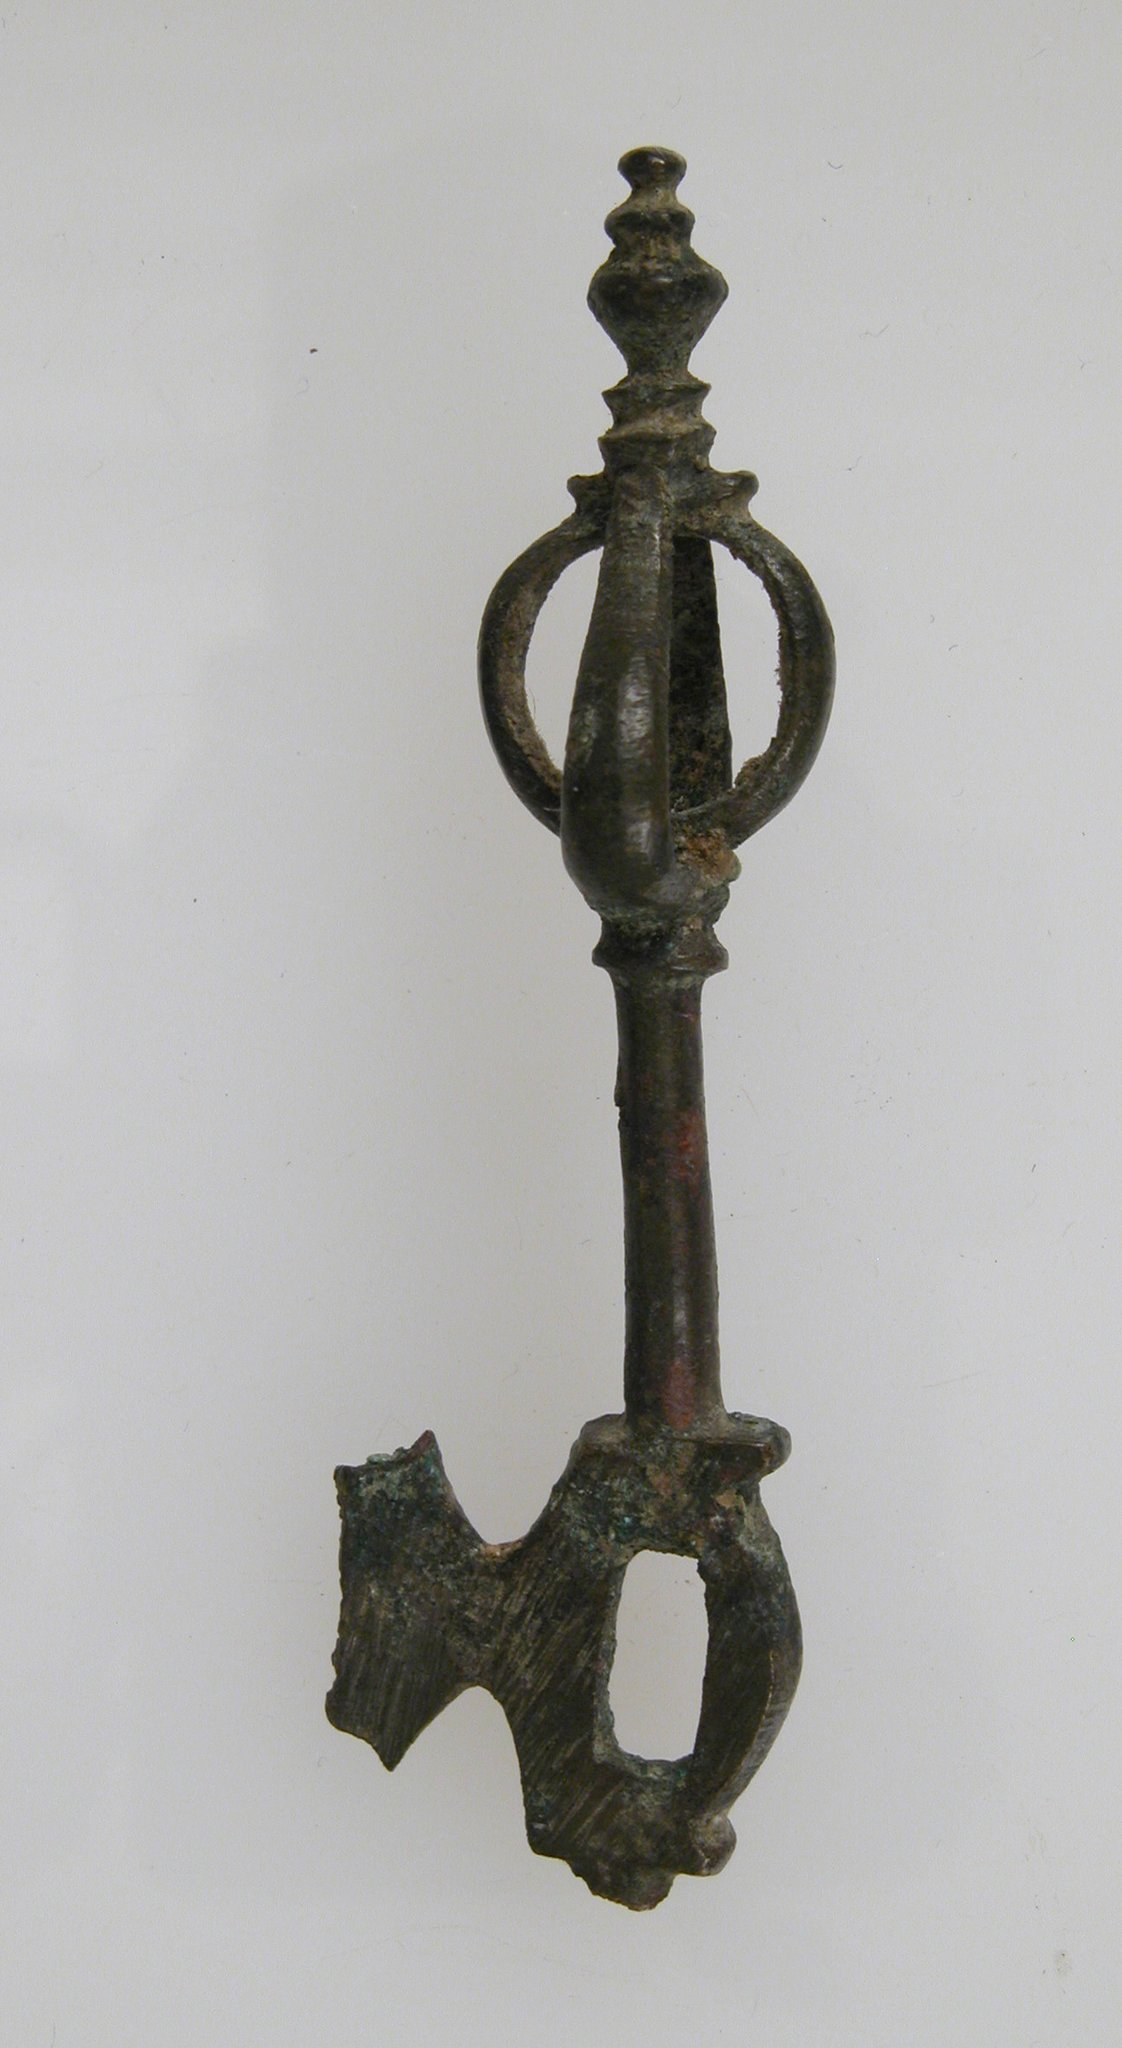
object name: key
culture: roman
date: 1-700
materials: copper alloy